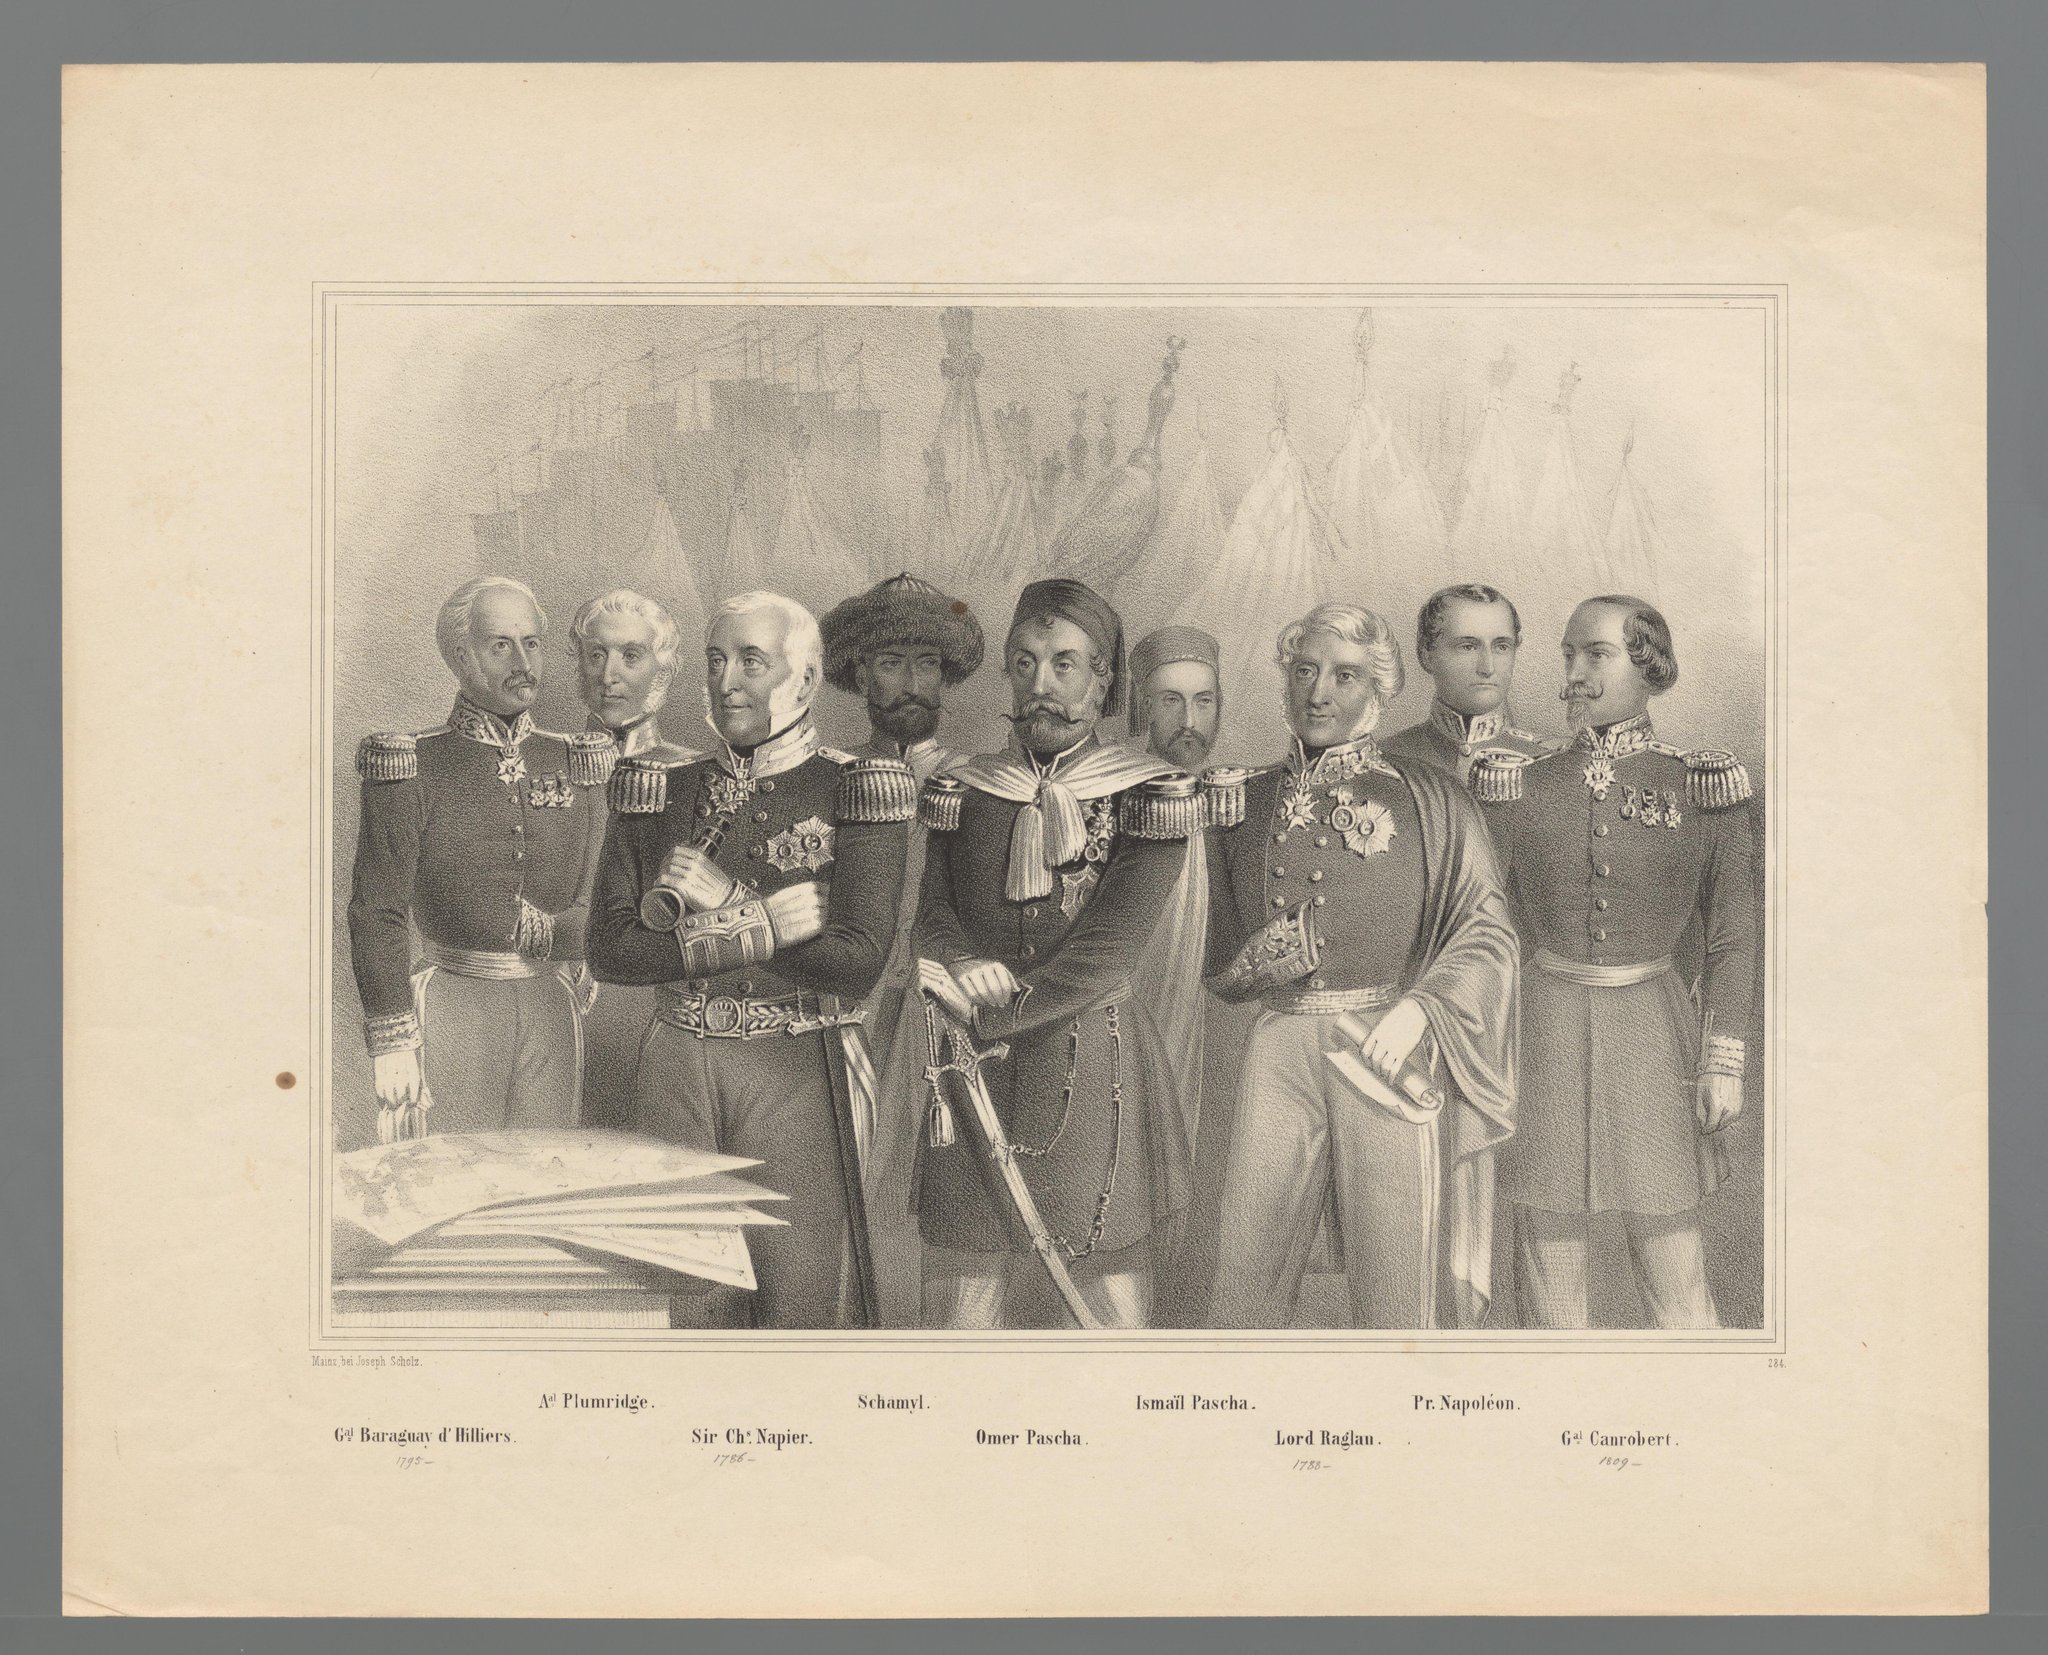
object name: print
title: Les défenseurs de la Turquie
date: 1853-1856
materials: paper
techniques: lithograph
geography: saint-gaudens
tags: victoria (koningin van het verenigd koninkrijk en keizerin van india), london, napoleon iii (keizer der fransen), naval officer, politician, paris, historical persons - bb - woman, commander-in-chief, general, marshal, historical persons, battle, ruler, sovereign, commander-in-chief, admiral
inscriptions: collector's mark, : ‘Déposé’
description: Met onder de portretten drie scènes uit de Krimoorlog: de Slag aan de Alma, het Beleg van Silistra en de Slag om Bomarsund.